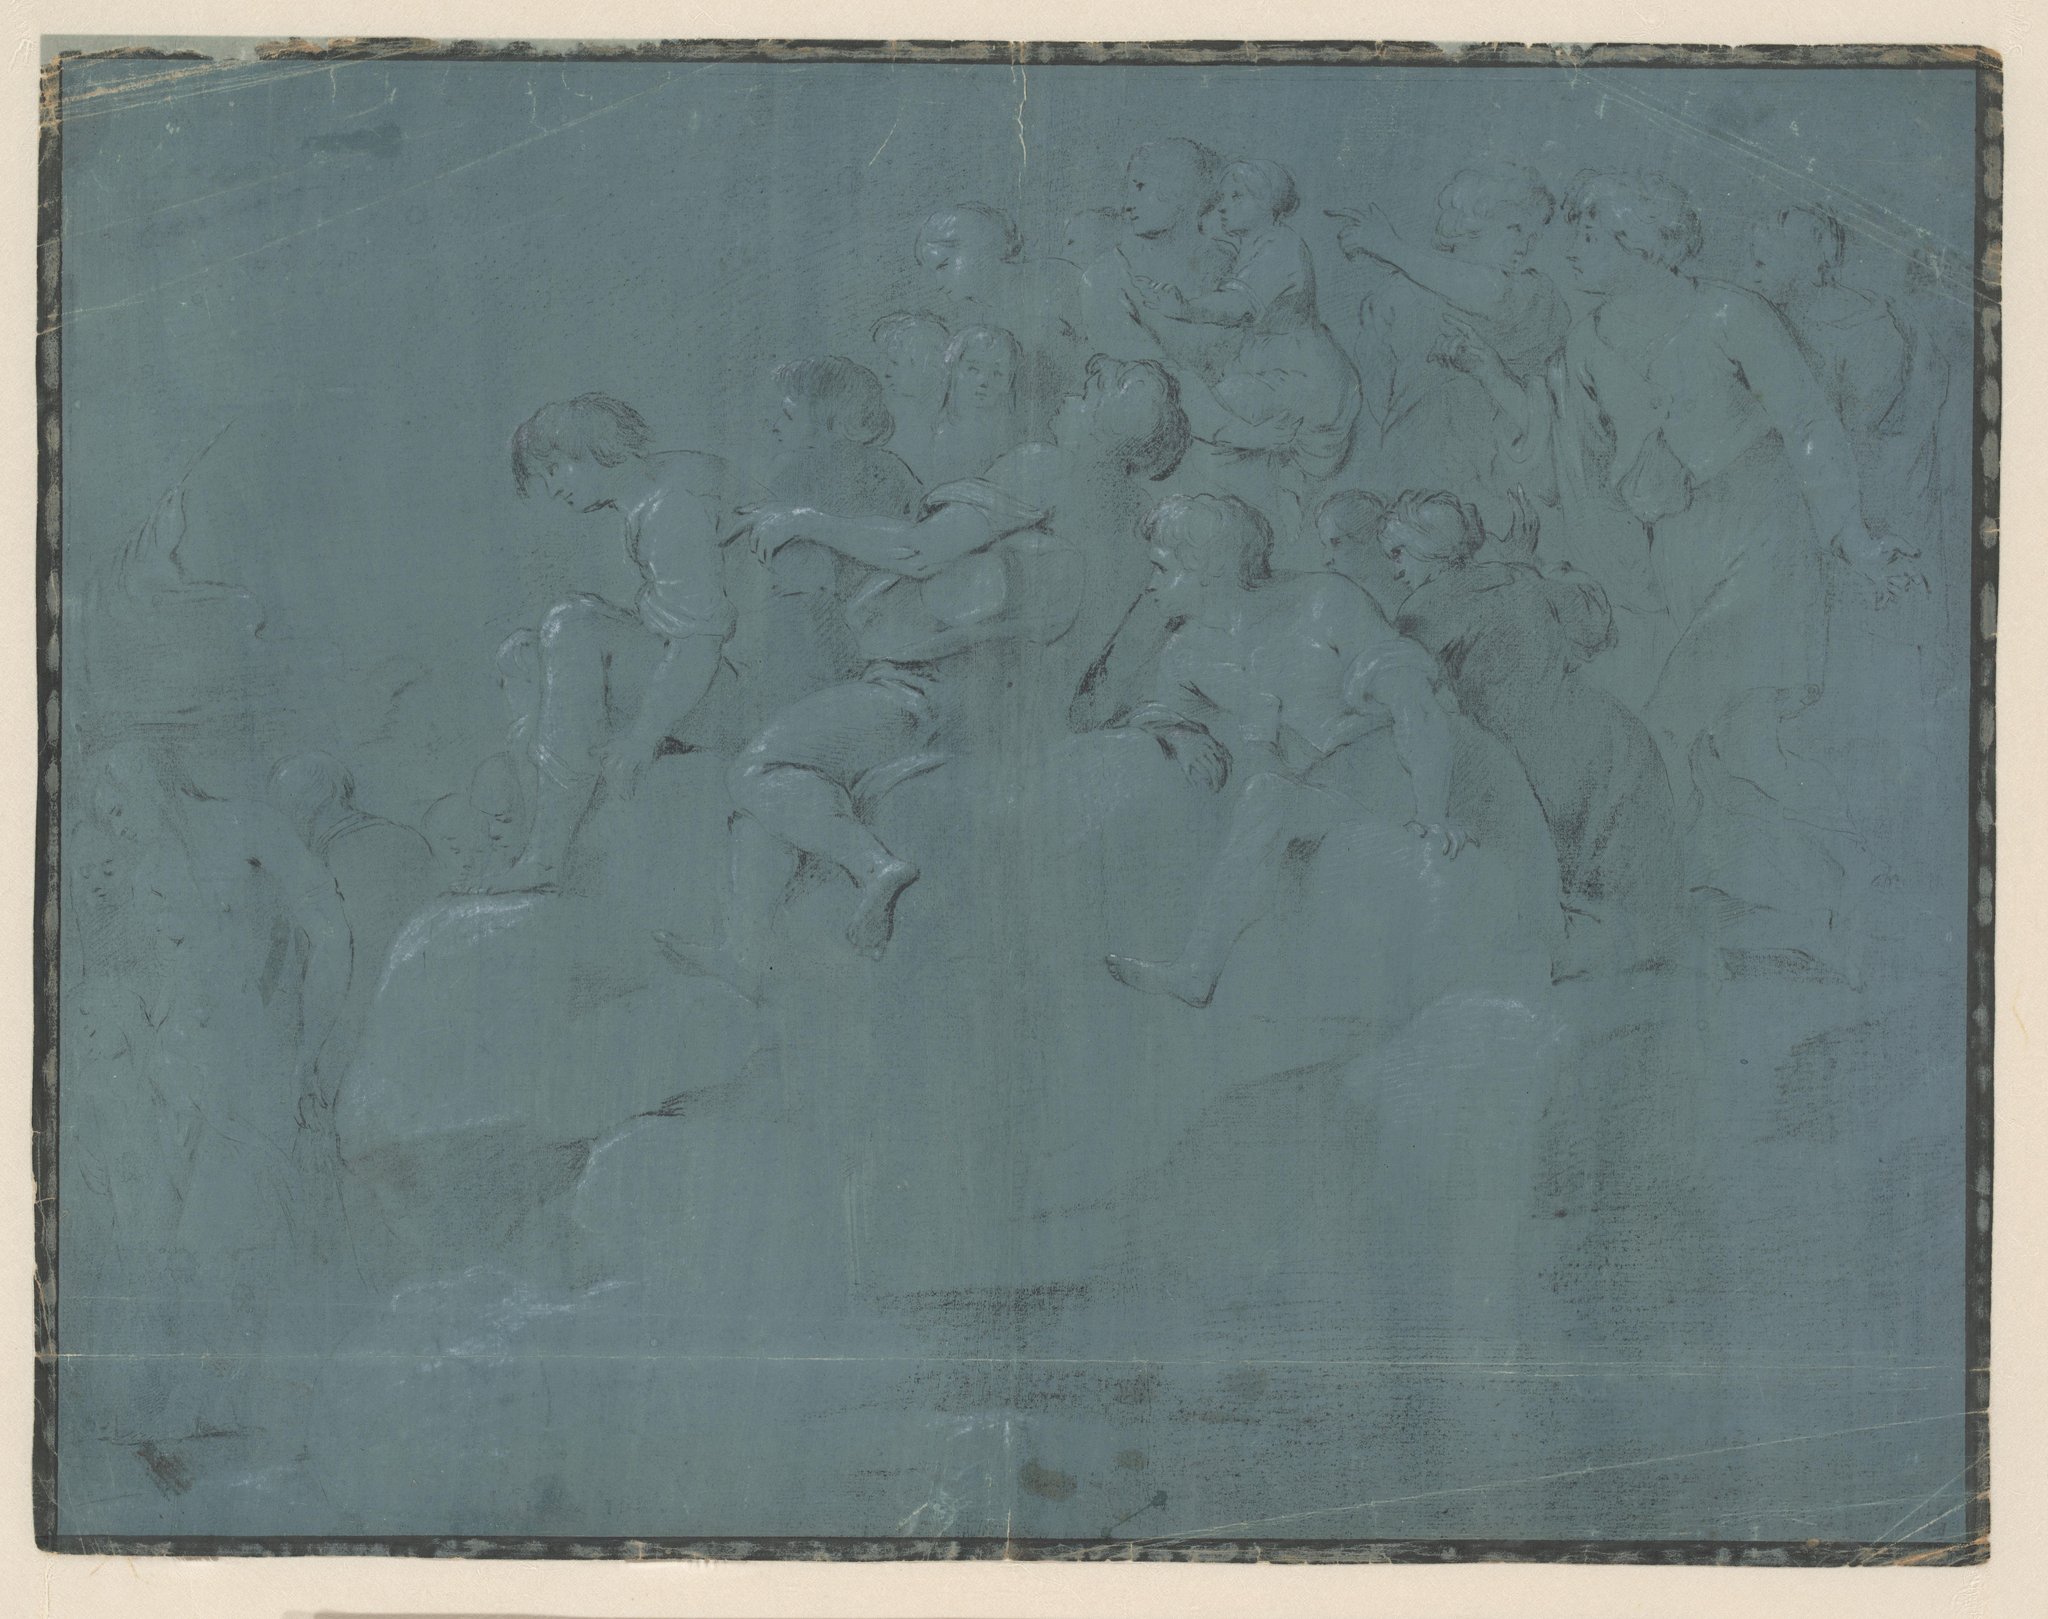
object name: drawing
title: Menigte op een heuvel of rots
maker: Anonymous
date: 1675-1699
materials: chalk, paper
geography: netherlands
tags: (high) hill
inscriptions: inscription: ‘1 x 3-3-0’, inscription: ‘Hendrick Goltius.Fecit.’, inscription: ‘uit pr. 5’